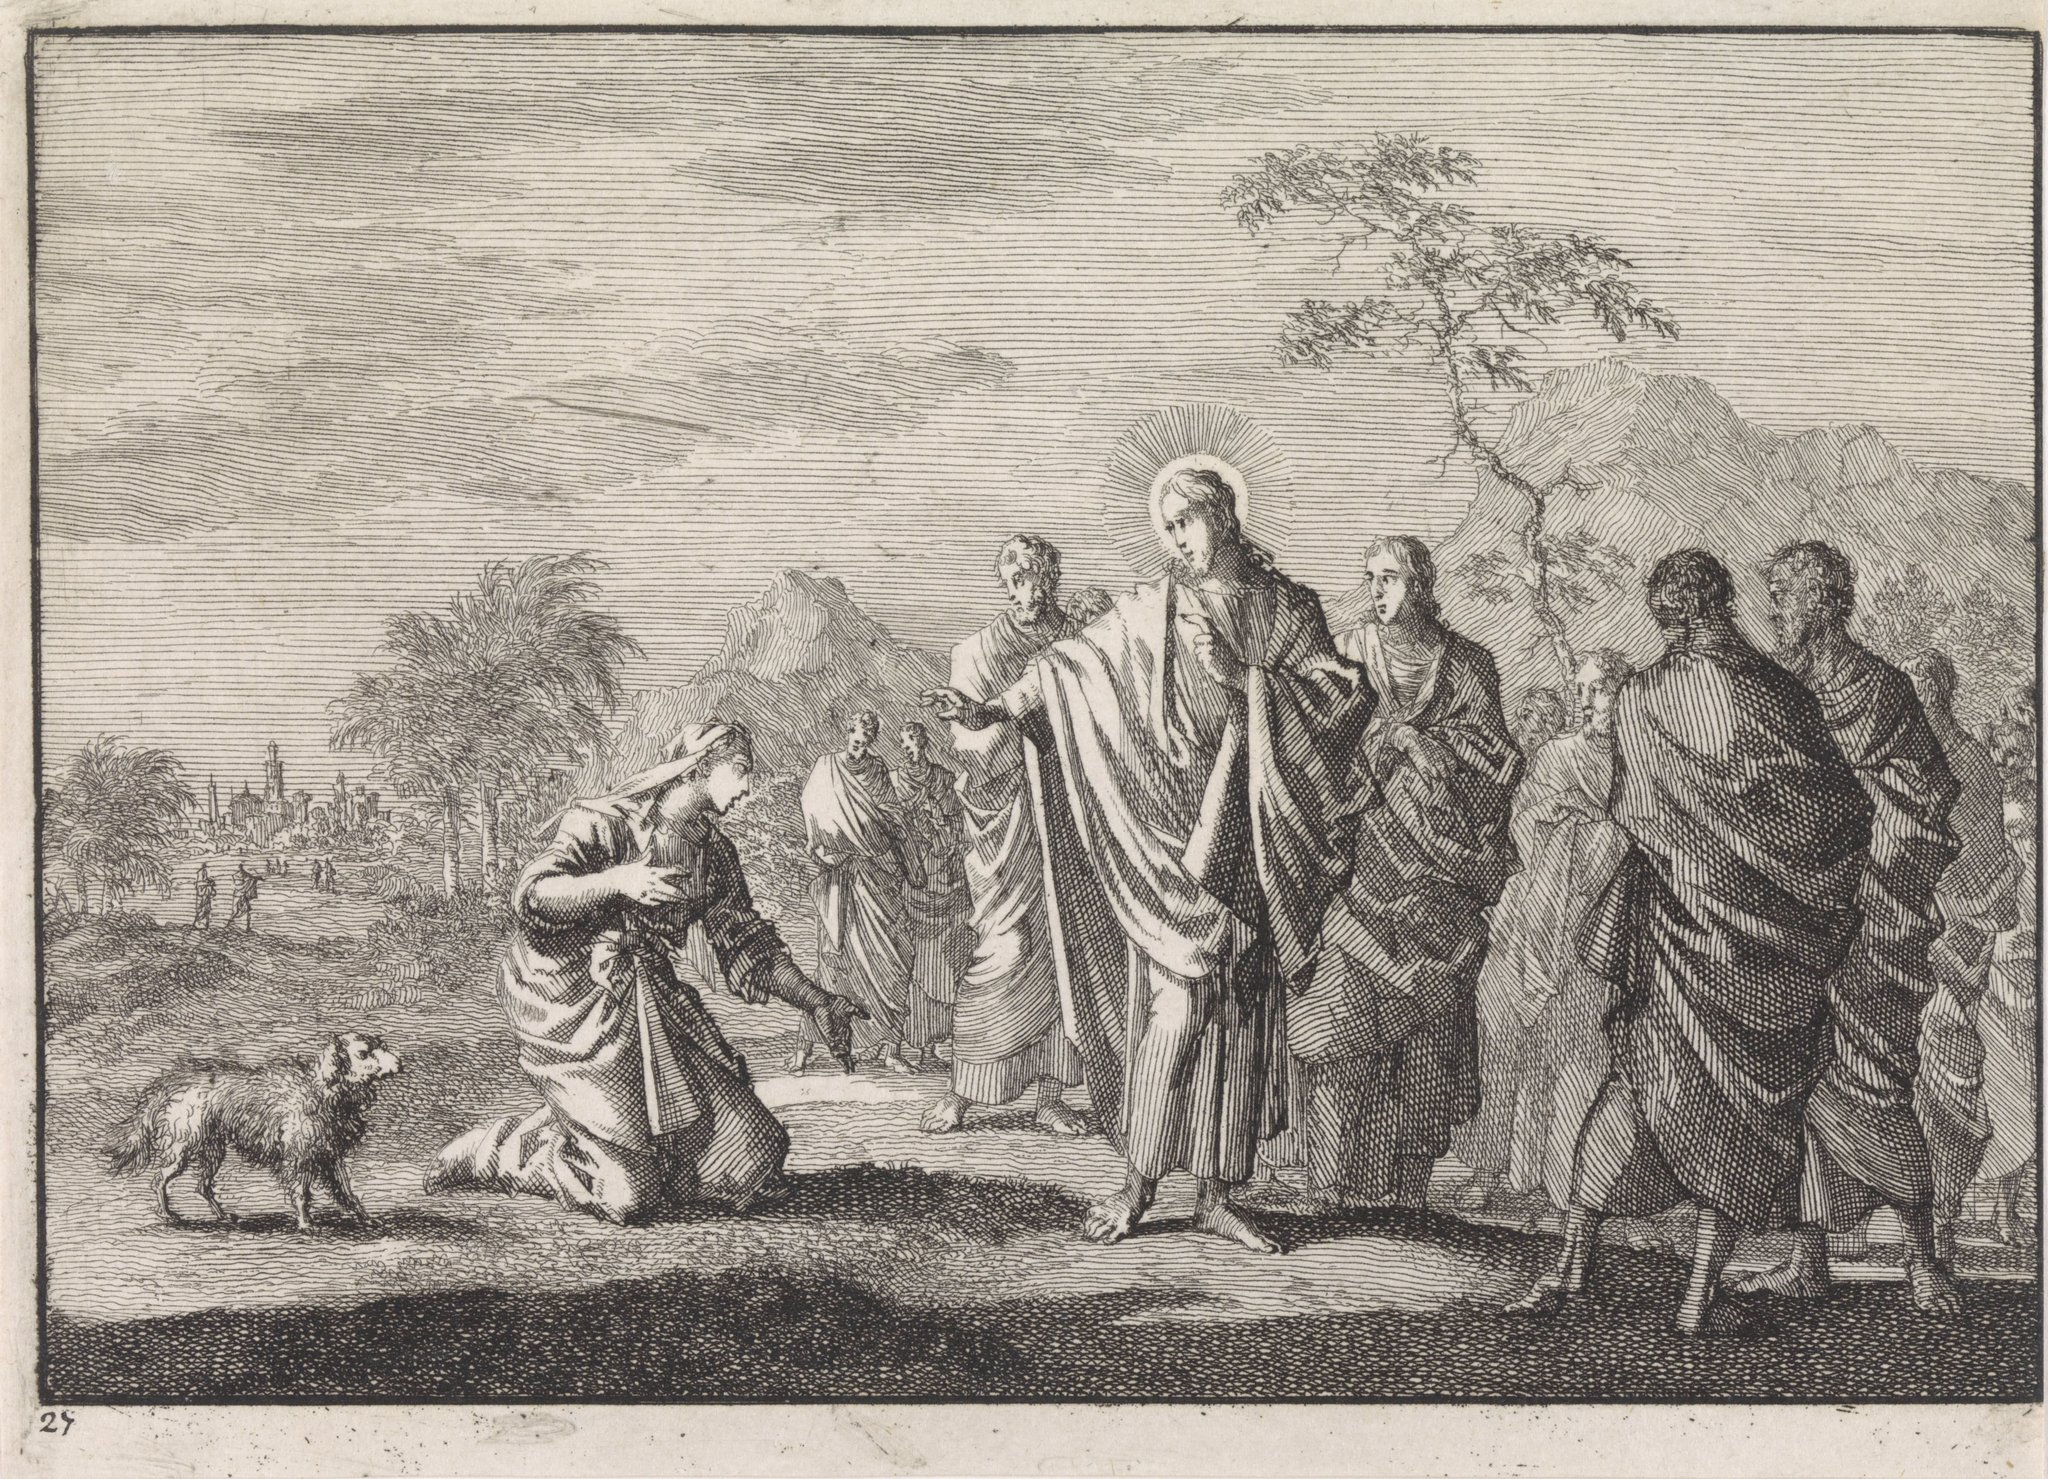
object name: print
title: Genezing van de dochter van de Kananese vrouw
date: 1703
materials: paper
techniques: etching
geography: amsterdam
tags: a canaanite woman kneels before christ, asking him to heal her daughter; the metaphor of the dogs and bread (matthew 15:21-28; mark 7:24-30)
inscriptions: collector's mark: Lugt 2228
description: Proefdruk van een boekillustratie voor David Martin. Historie des Ouden en Nieuwen Testaments. Amsterdam, Pieter Mortier, 1703. Deel II. De boekillustraties voor de Mortierbijbel hebben verschillende staten en kopieën, waarbij de chronologische volgorde moeilijk te achterhalen valt. Als boekillustraties werden ze bovendien herhaaldelijk opnieuw gebruikt voor andere boekwerken.